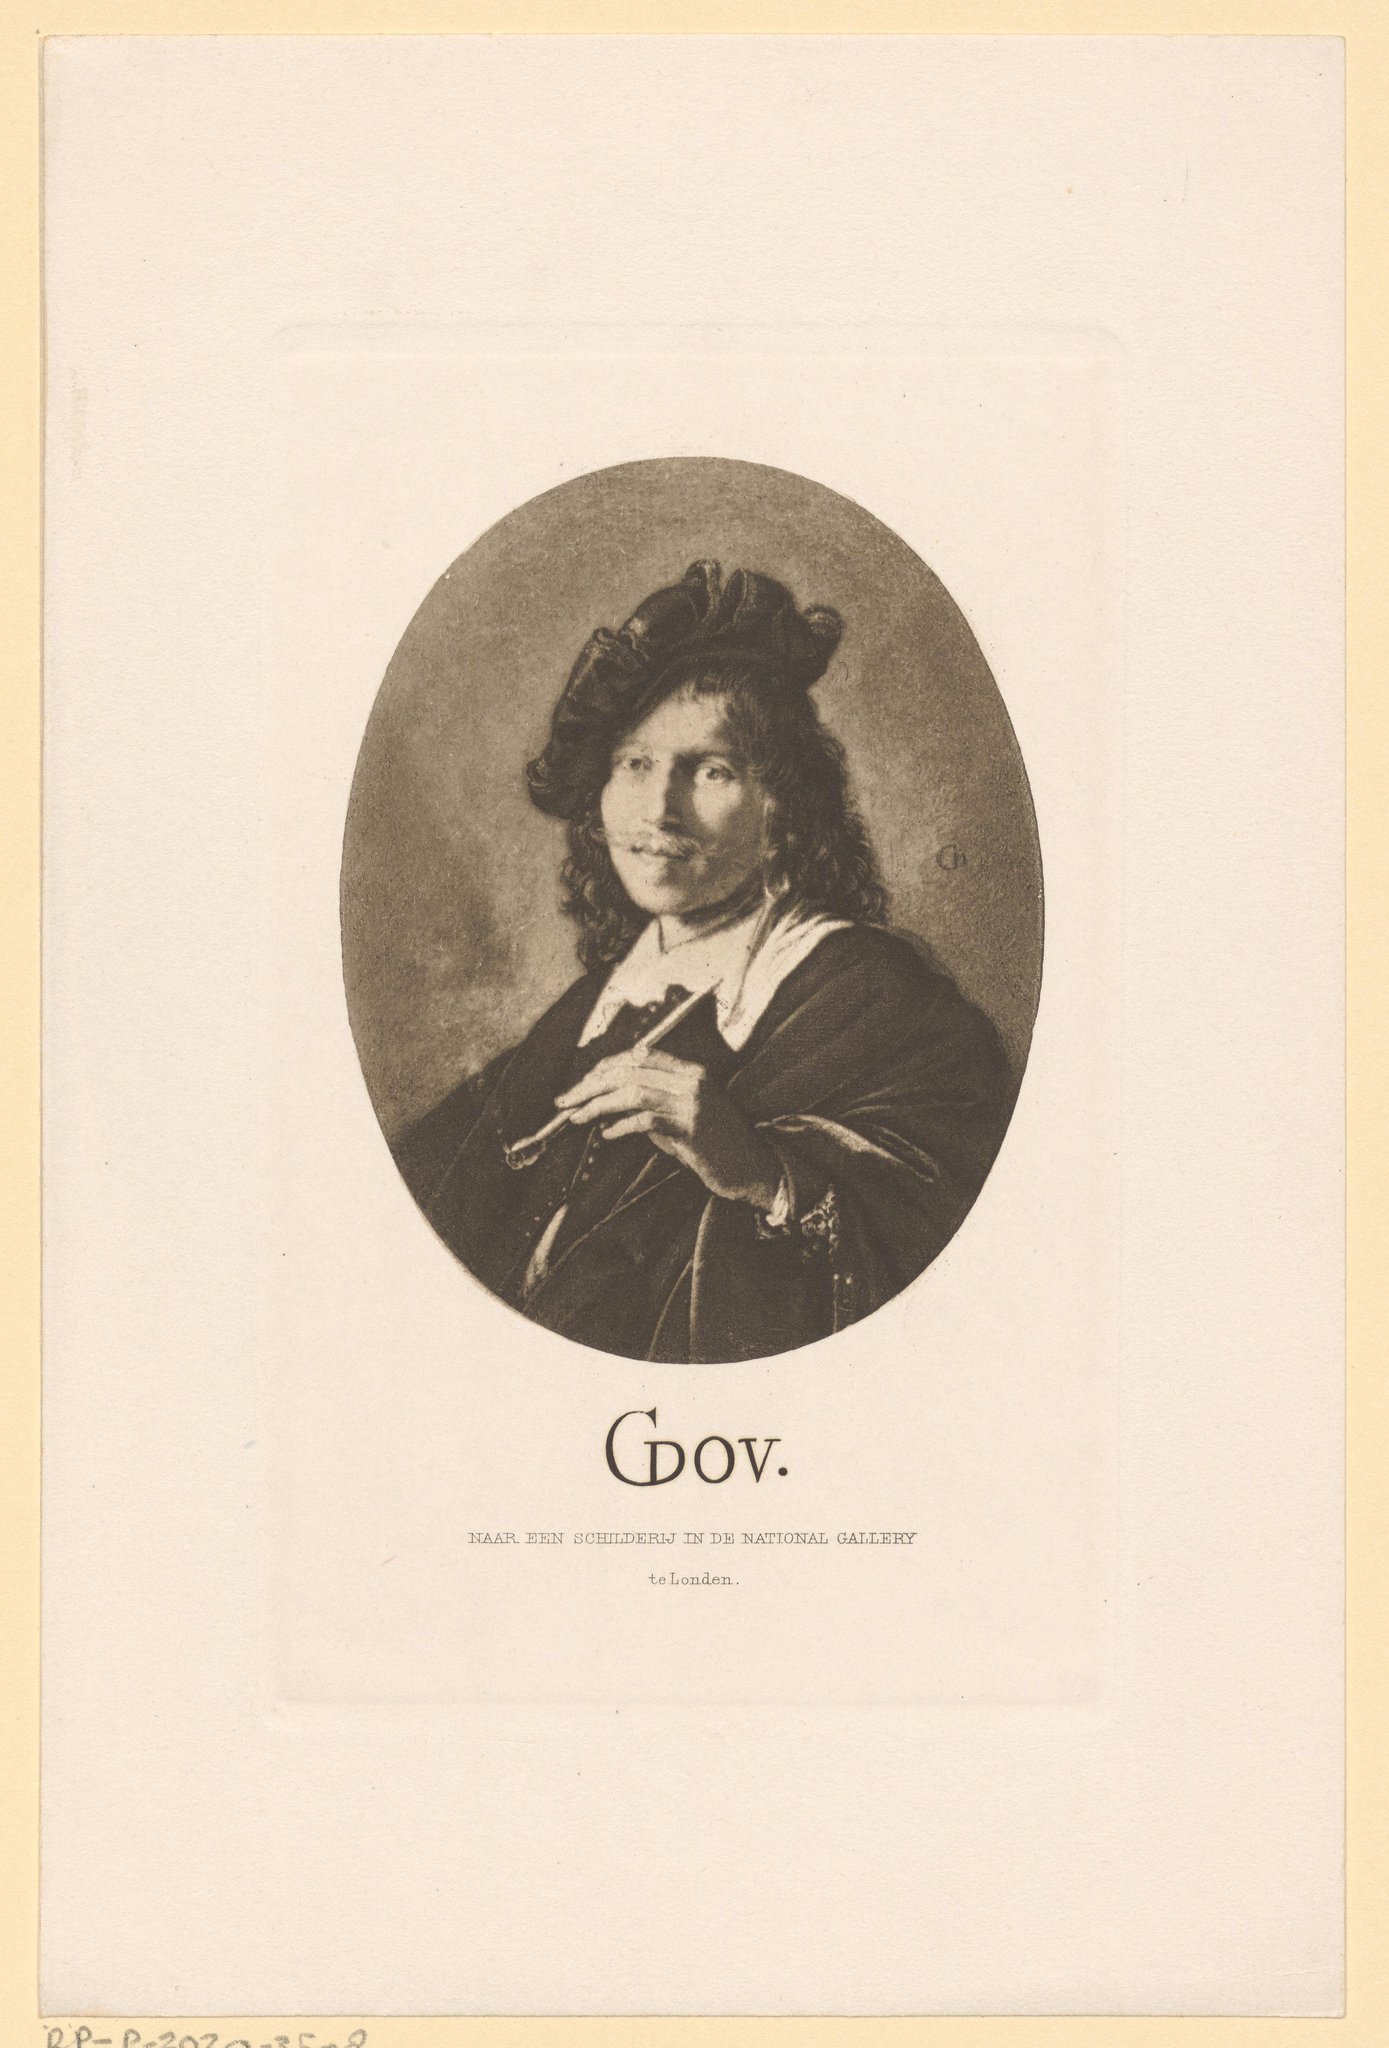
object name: photomechanical print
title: Portret van Gerard Dou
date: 1870-1915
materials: paper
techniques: photoaquatint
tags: leiden, painter, draughtsman, gerard dou, historical persons, portrait, self-portrait of artist